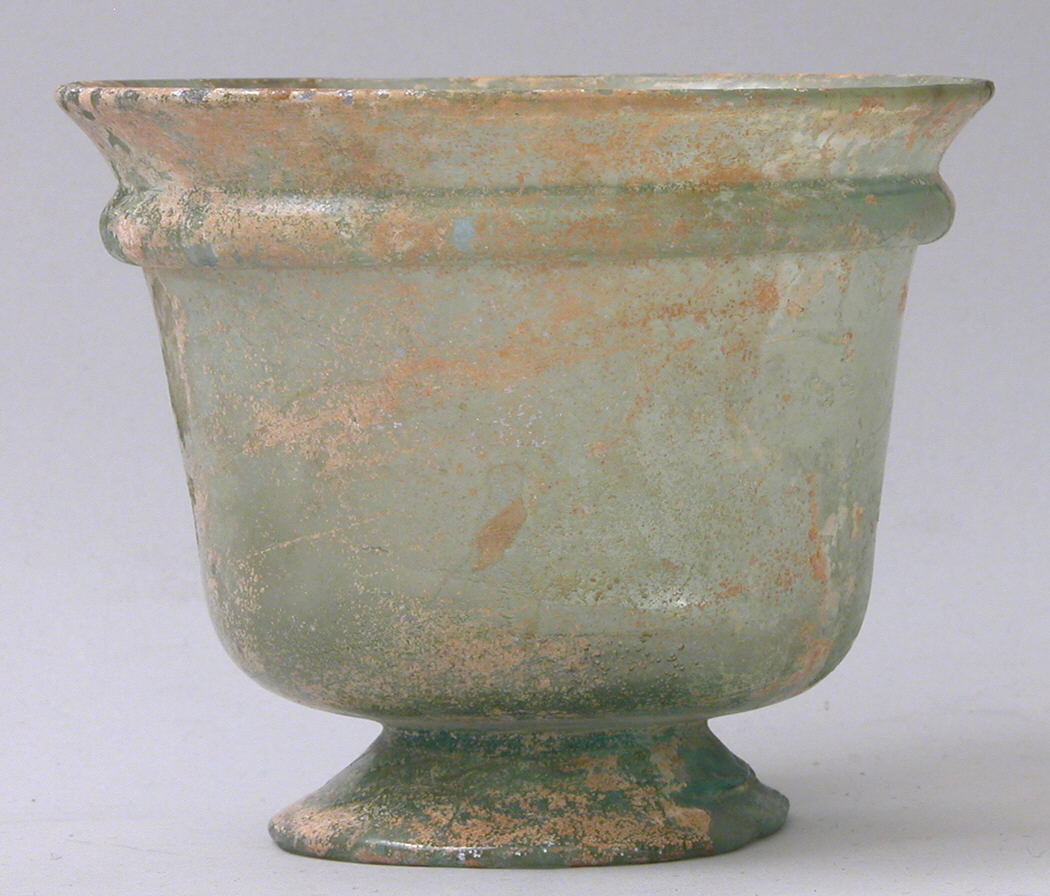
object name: cup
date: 301-500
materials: glass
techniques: glassblowing, tooling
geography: iran